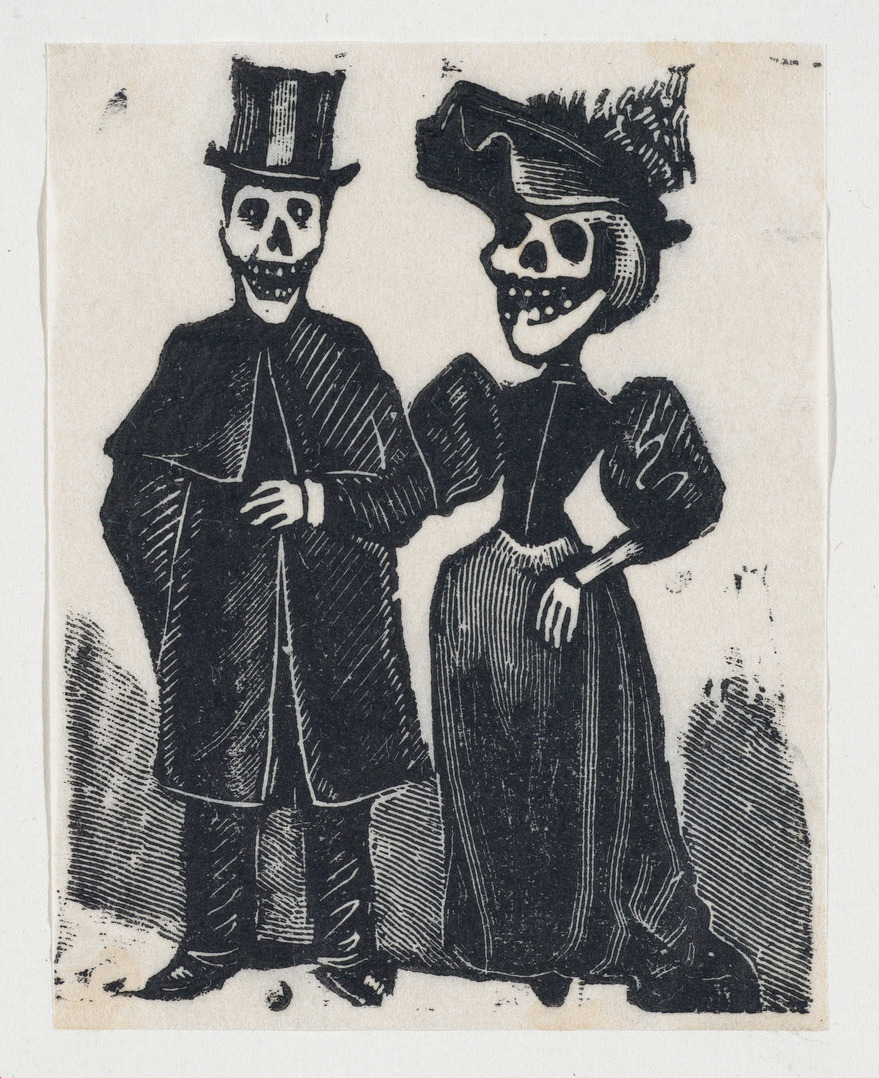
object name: print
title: Elegantly dressed male and female skeletons arm in arm (vignette for the feast of the dead)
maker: josé guadalupe posada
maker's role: artist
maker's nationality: mexican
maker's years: 1852-1913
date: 1894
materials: metal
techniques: engraving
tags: skeletons,men,women